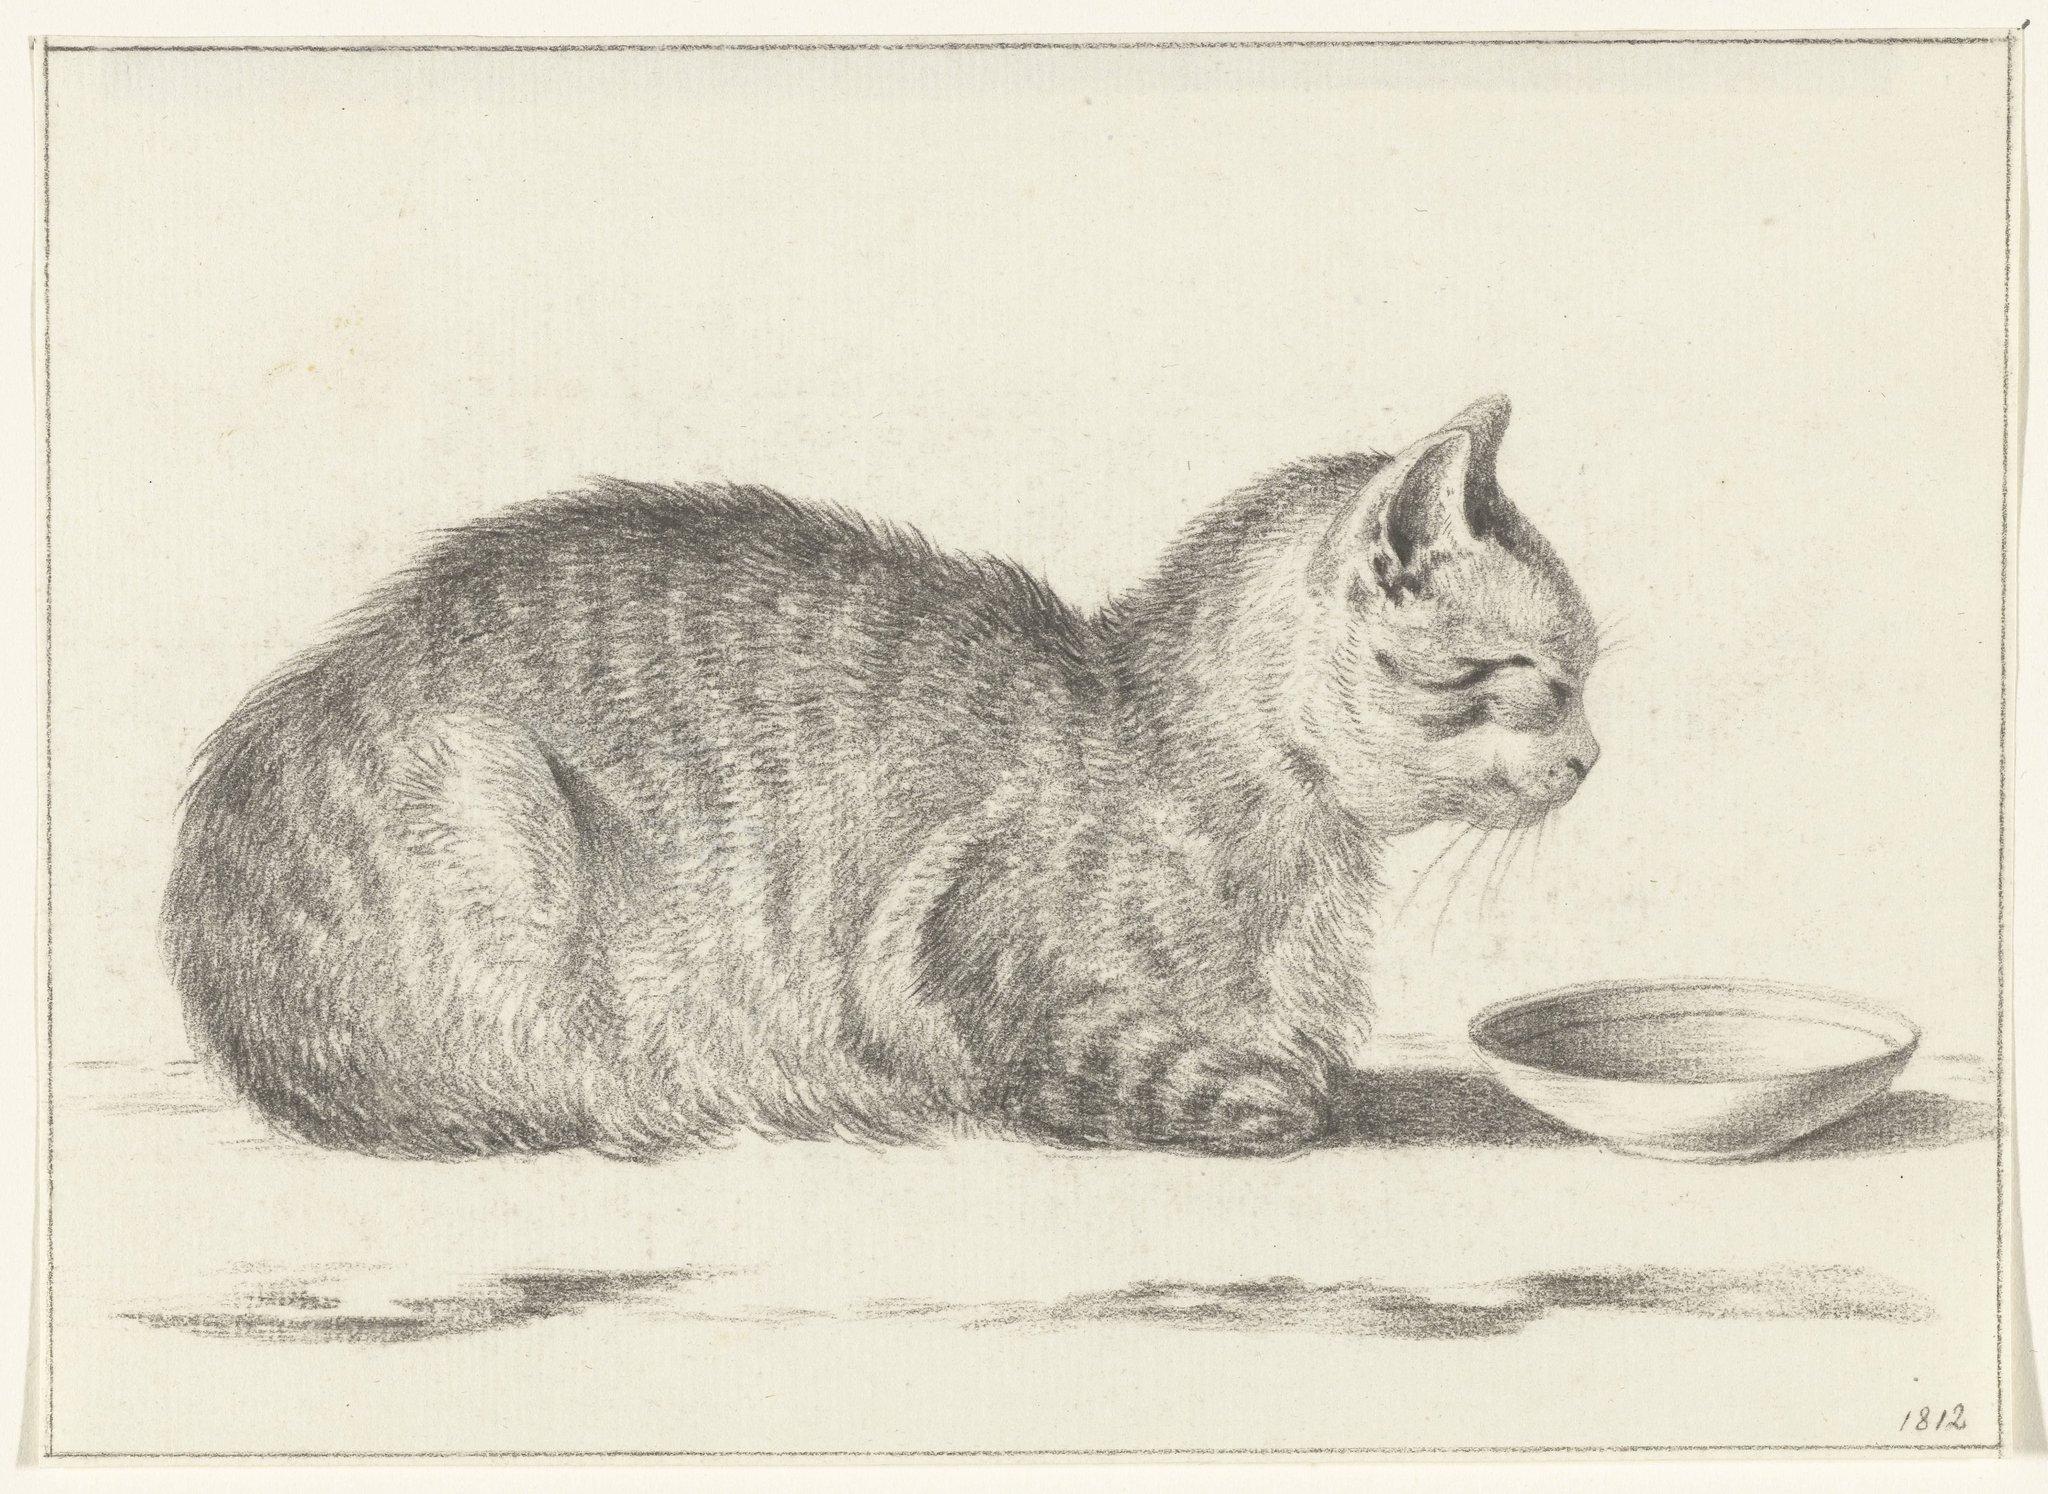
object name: drawing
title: Liggende kat, naar links, voor een schotel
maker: jean bernard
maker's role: draughtsman, print maker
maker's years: 1765-1833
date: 1812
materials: chalk, paper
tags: cat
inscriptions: date: ‘1812’